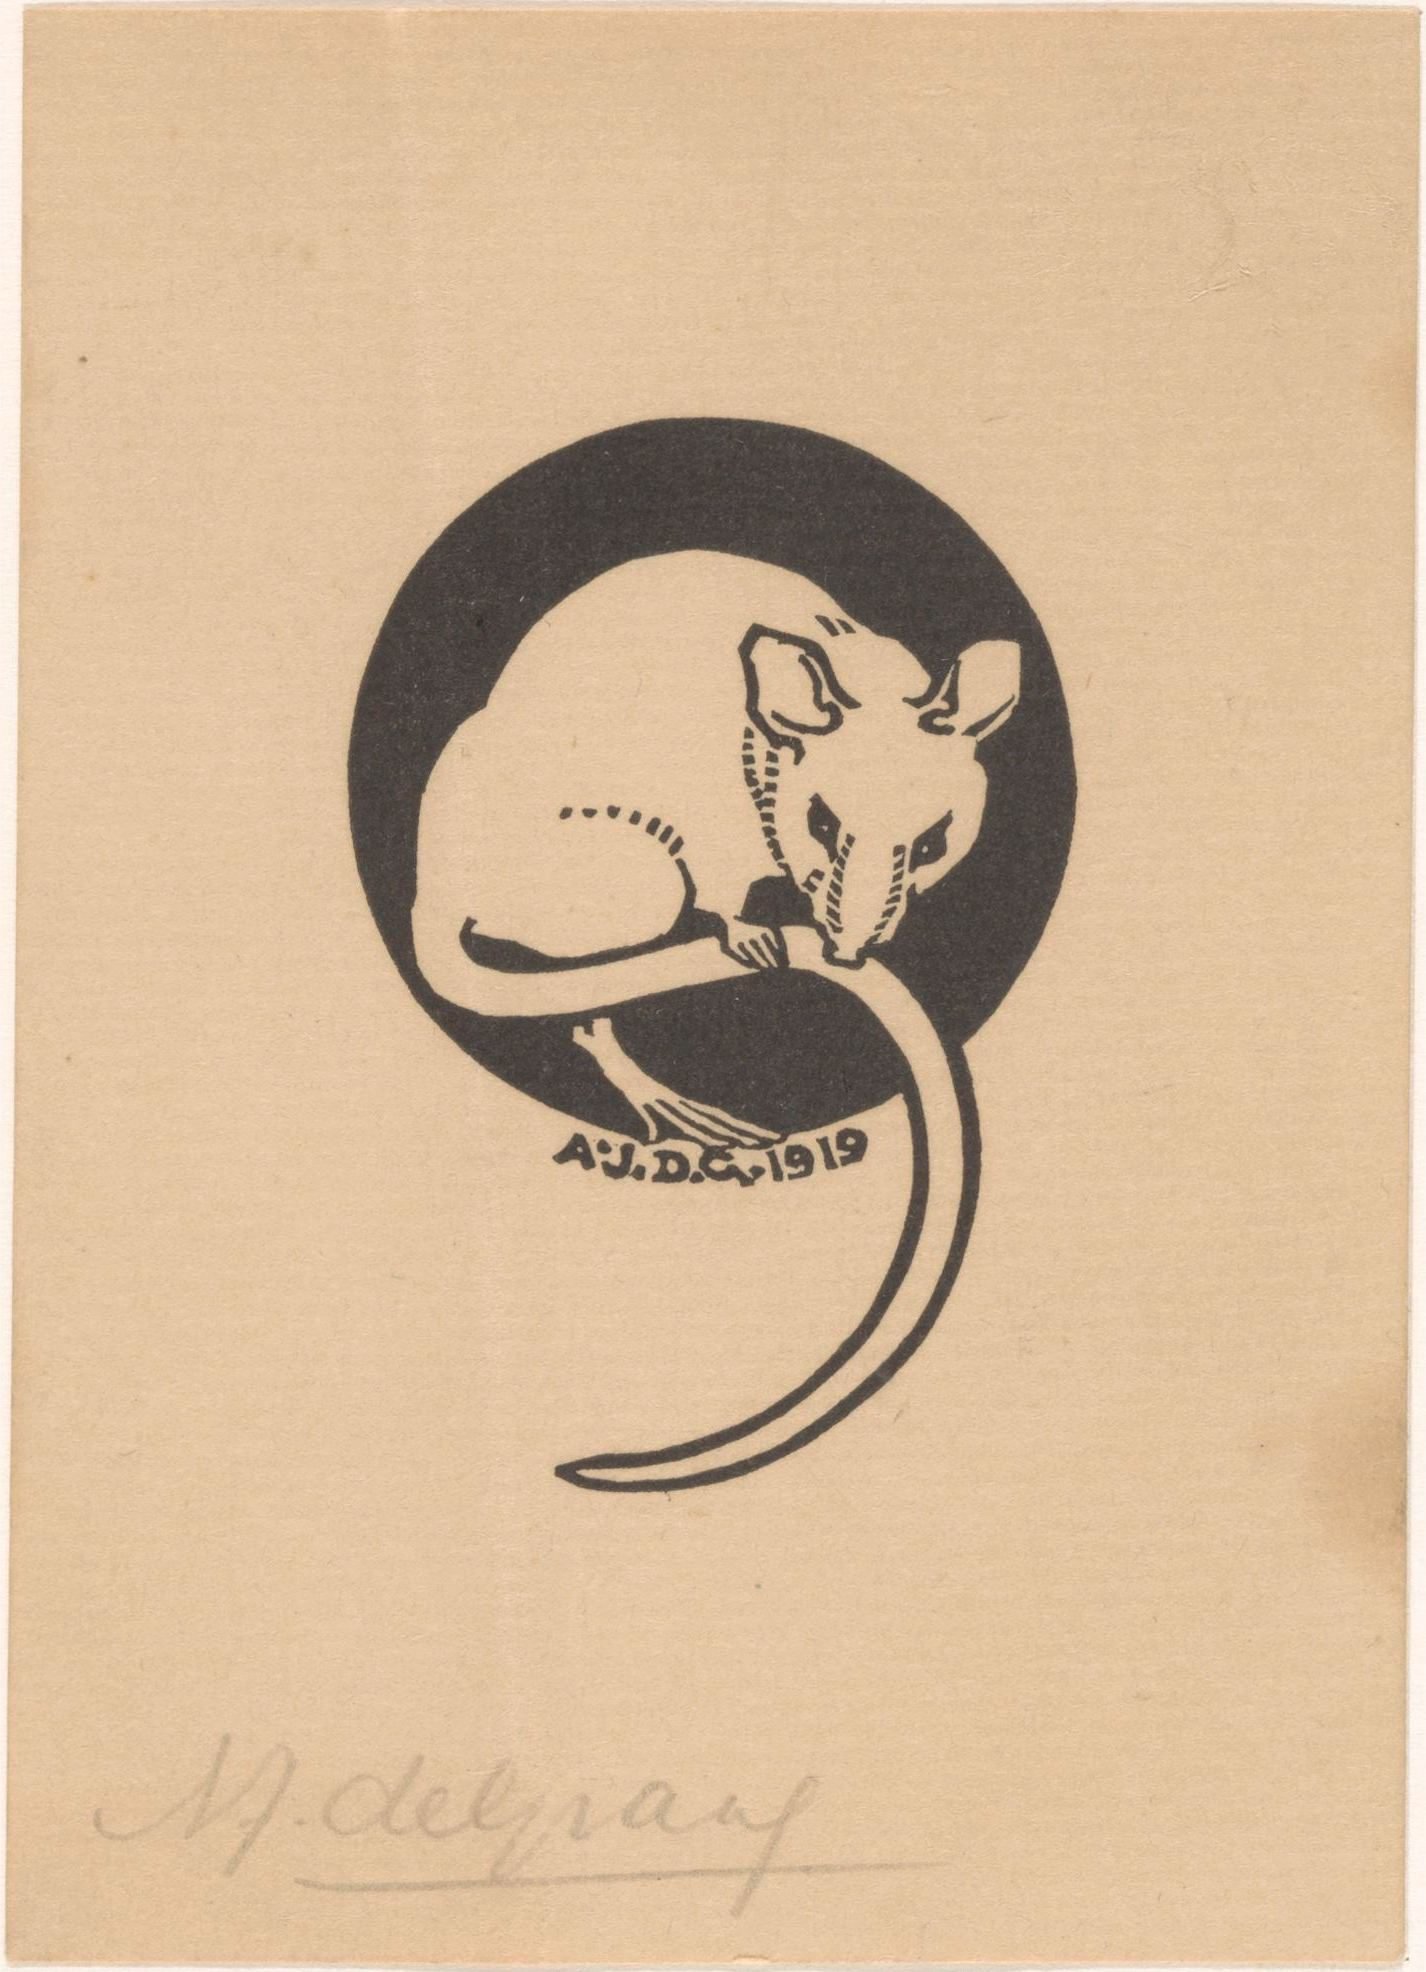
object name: print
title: Muis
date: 1919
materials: paper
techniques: woodcut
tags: rodents: mouse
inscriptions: collector's mark: Lugt 2228